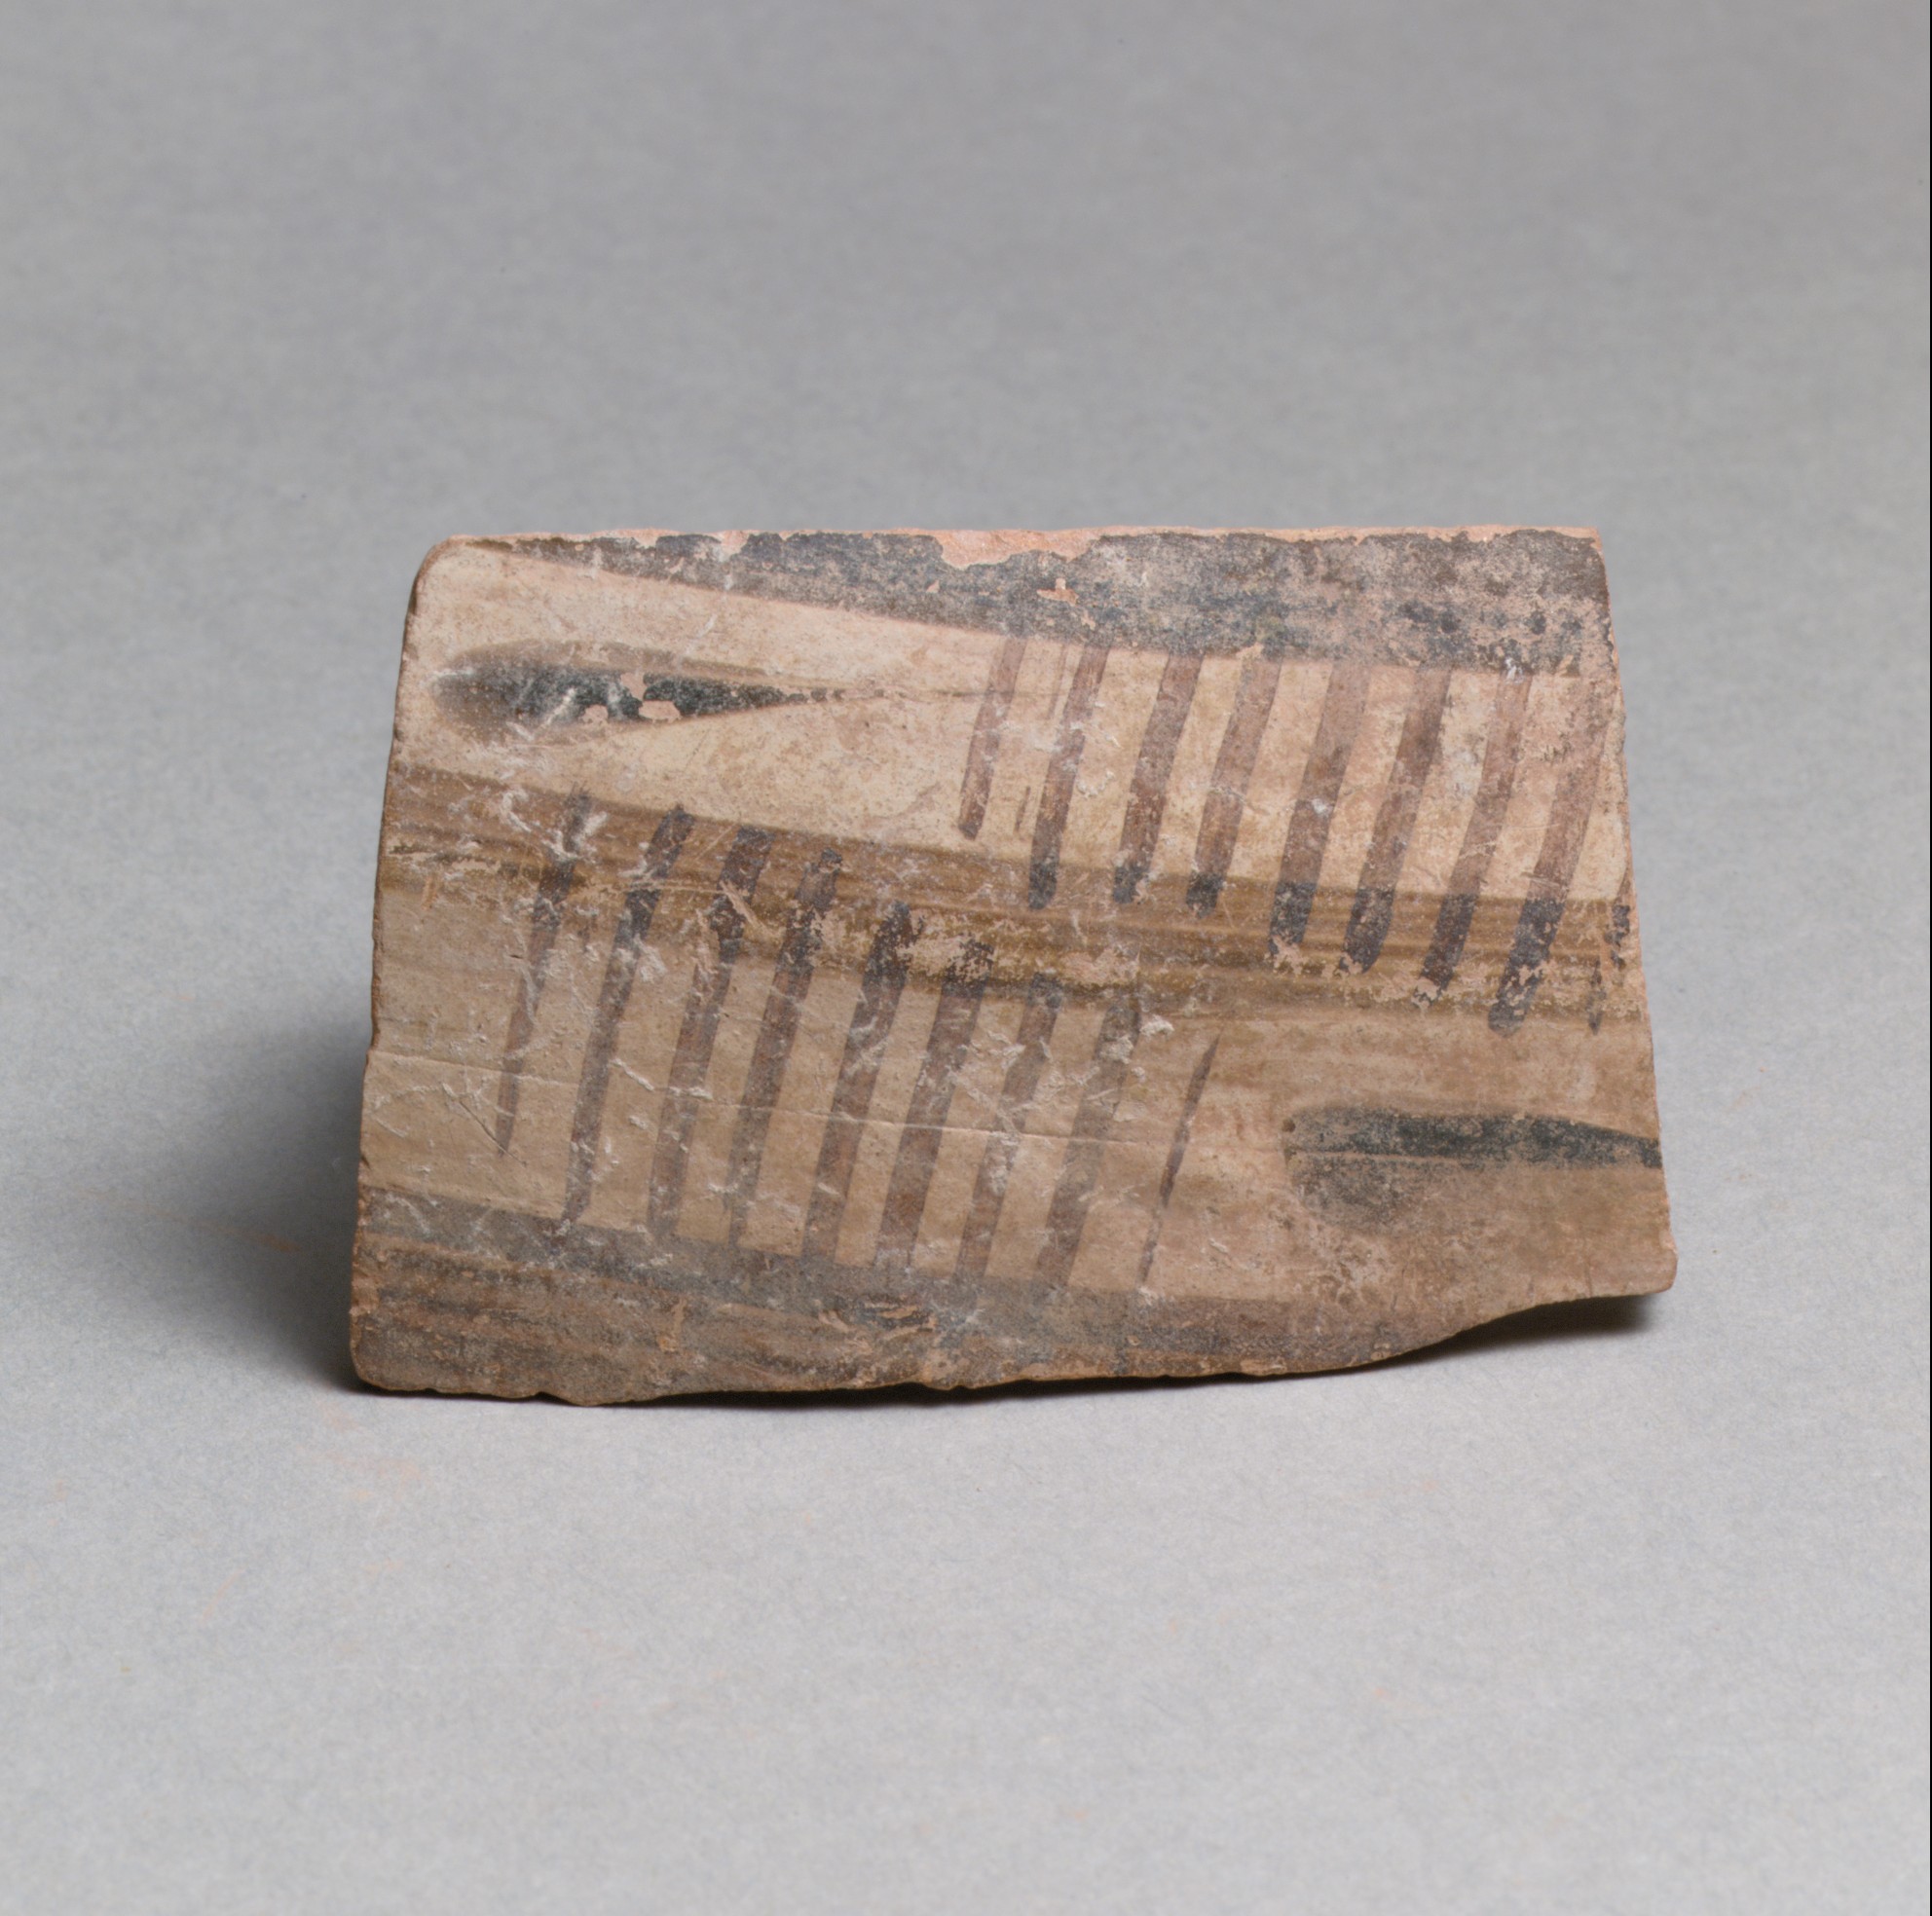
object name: vase fragment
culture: greek or lydian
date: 1050-700 BCE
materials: terracotta